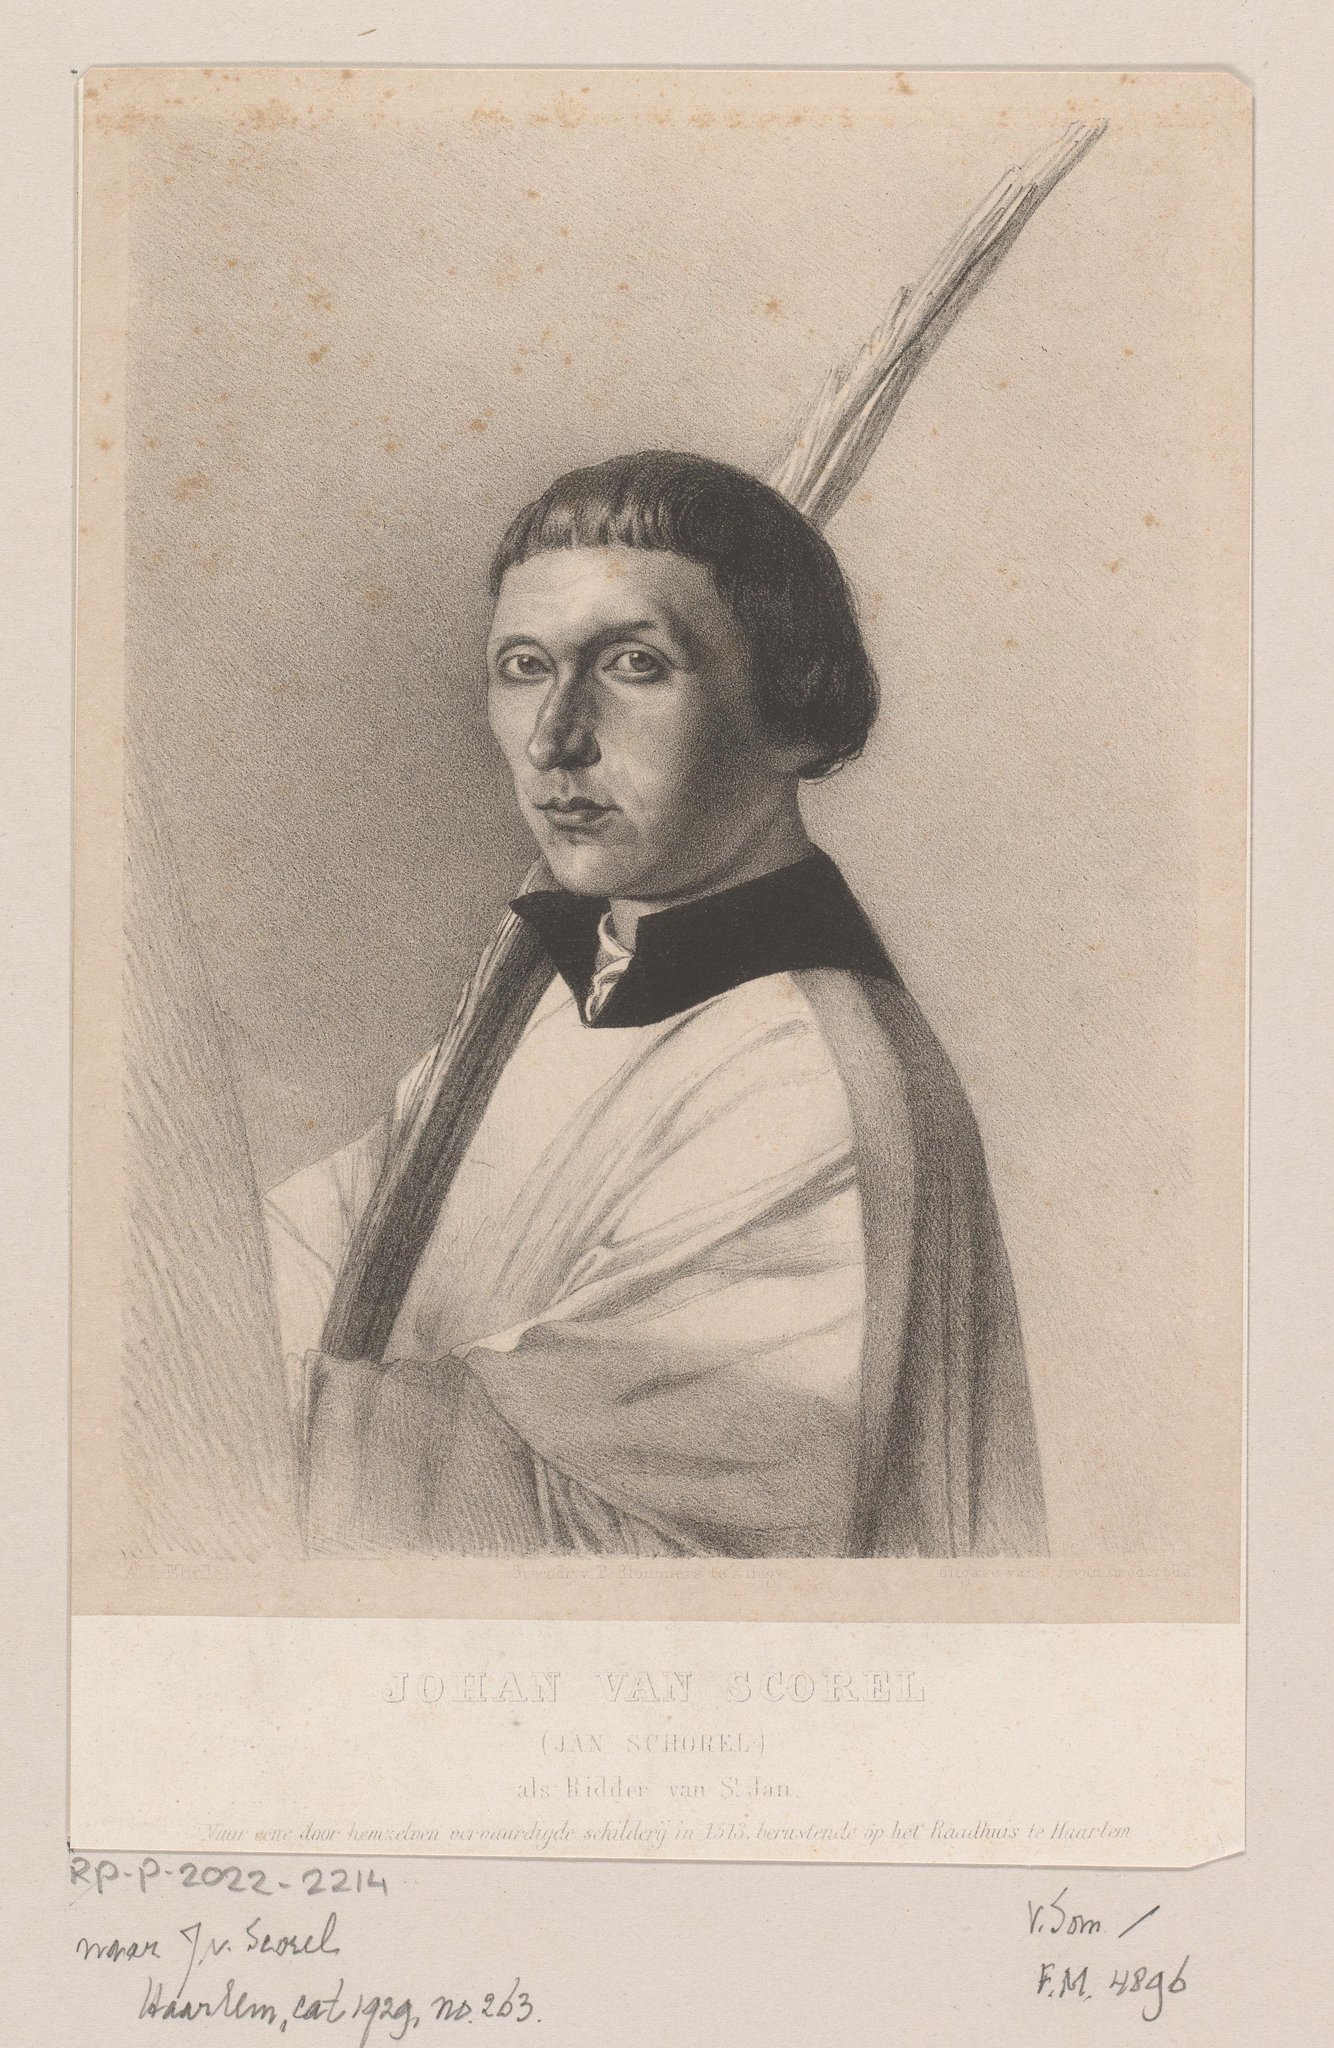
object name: print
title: Portret van Jan van Scorel als ridder van Sint-Jan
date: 1847-1863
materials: paper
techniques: lithograph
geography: haarlem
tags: painter, print maker, jan van scorel, historical persons, portrait, self-portrait of artist, knight